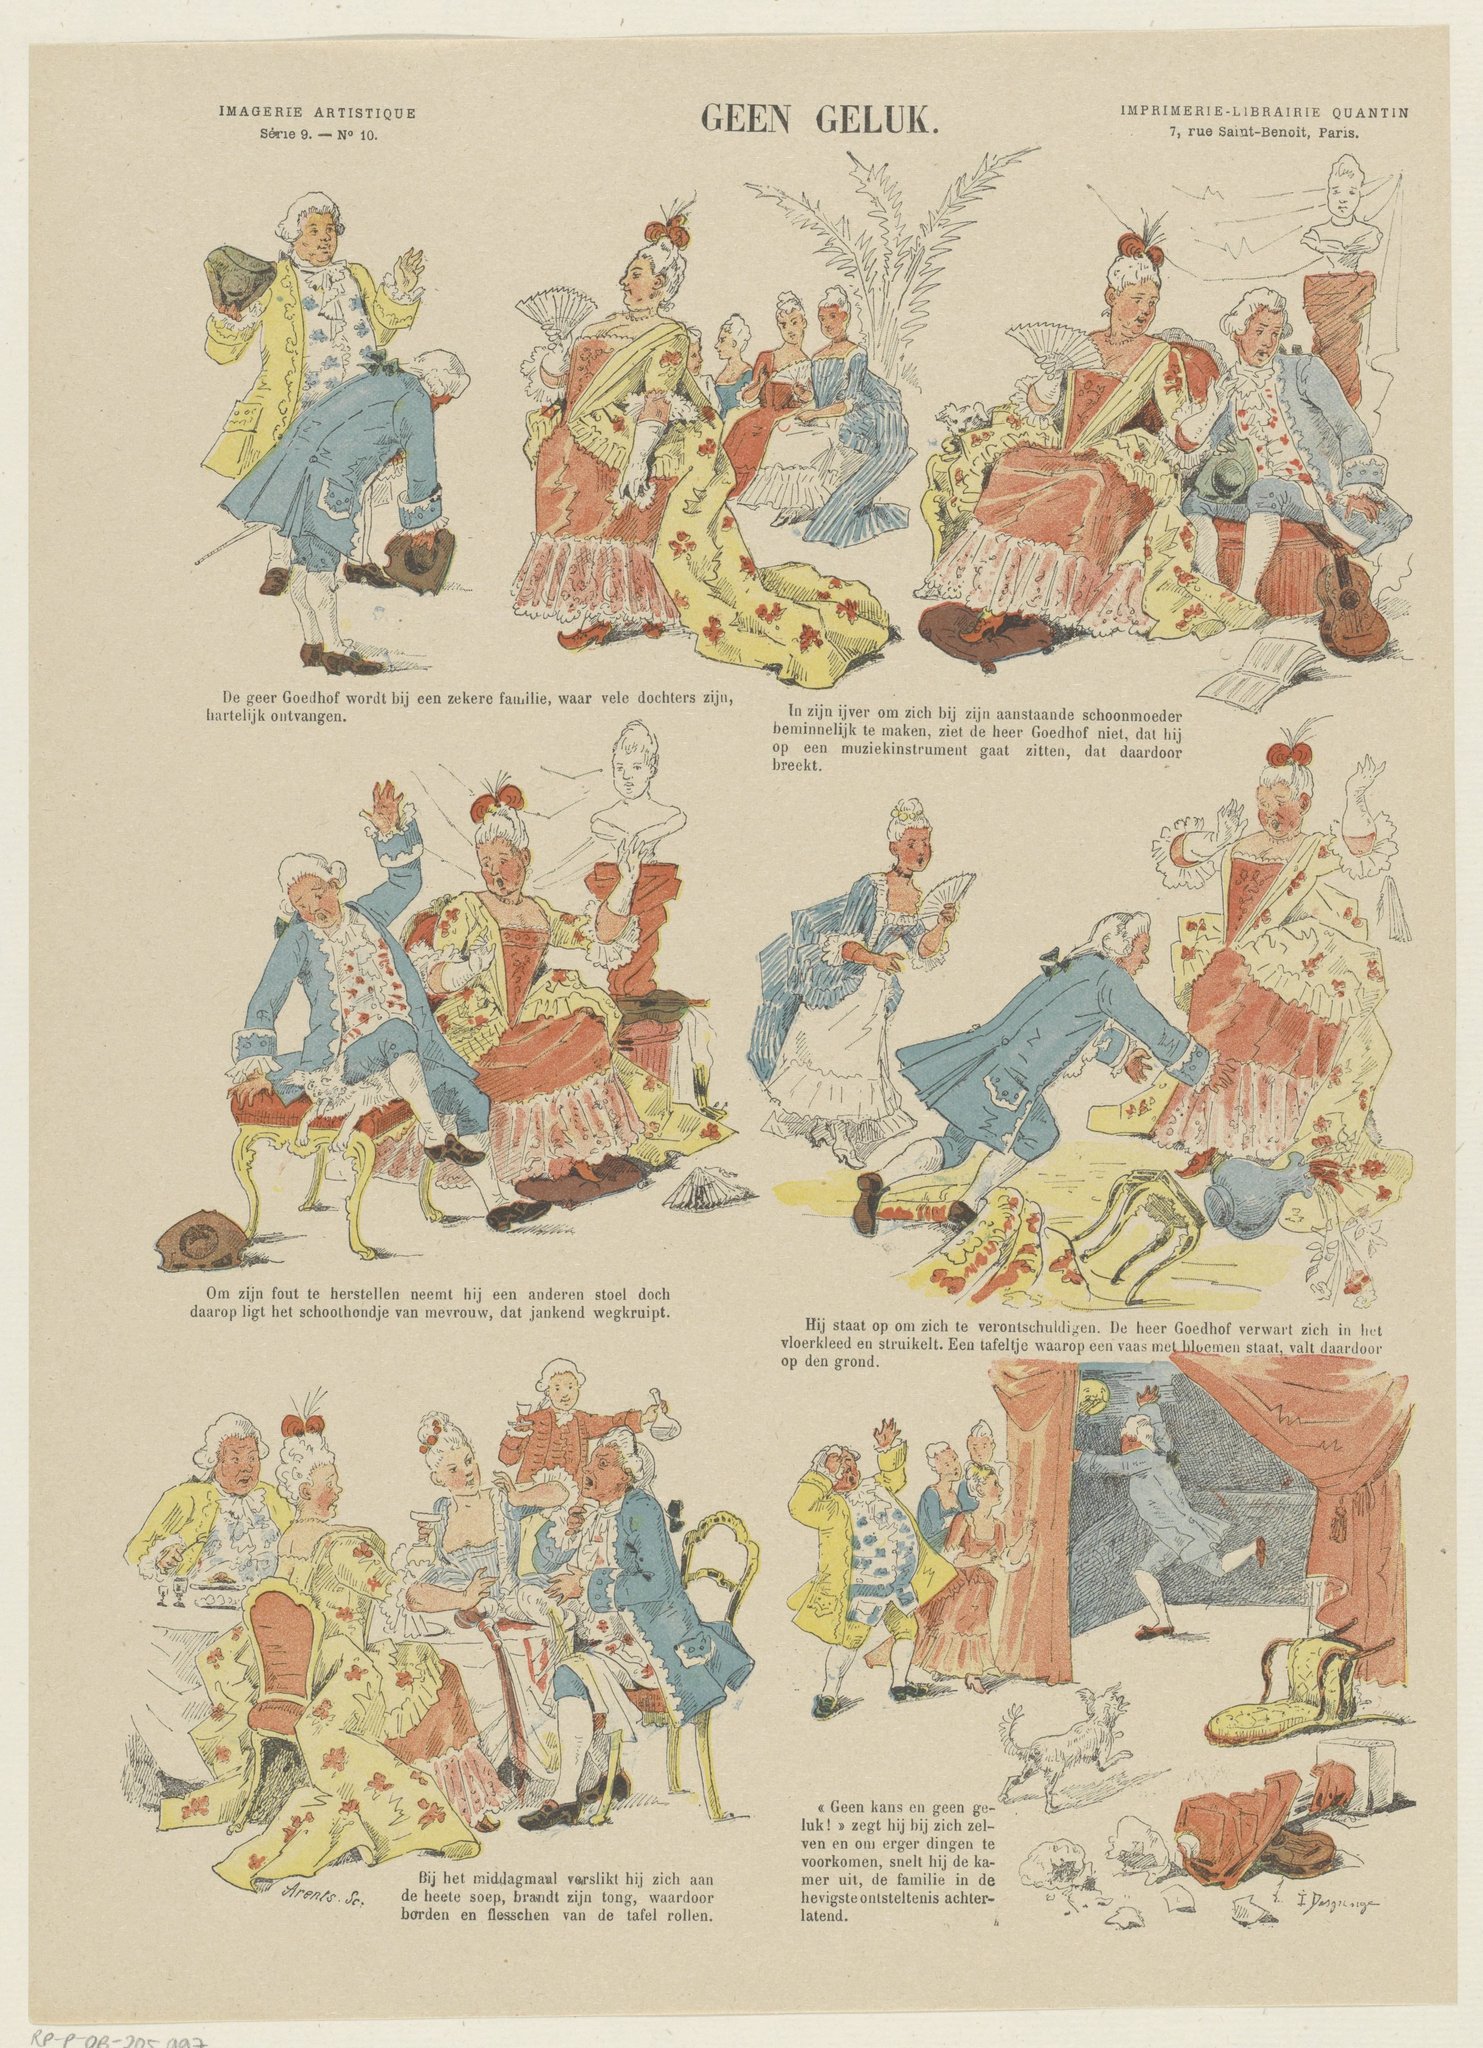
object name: print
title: Geen geluk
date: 1876-1890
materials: paper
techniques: lithograph, letterpress printing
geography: paris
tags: adversity, misfortune, bad luck; 'fortuna infelice', 'infortunio' (ripa), tales and fairy tales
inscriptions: collector's mark: Lugt 2760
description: Blad met 6 voorstellingen van de heer Goedhof die op bezoek gaat, waarbij van alles mis gaat. Hij breekt een muziekinstrument, een vaas, gaat op de hond zitten en verslikt zich bij de maaltijd hevig. Onder elke afbeelding een onderschrift. Genummerd linksboven: Série 9. - No. 10.